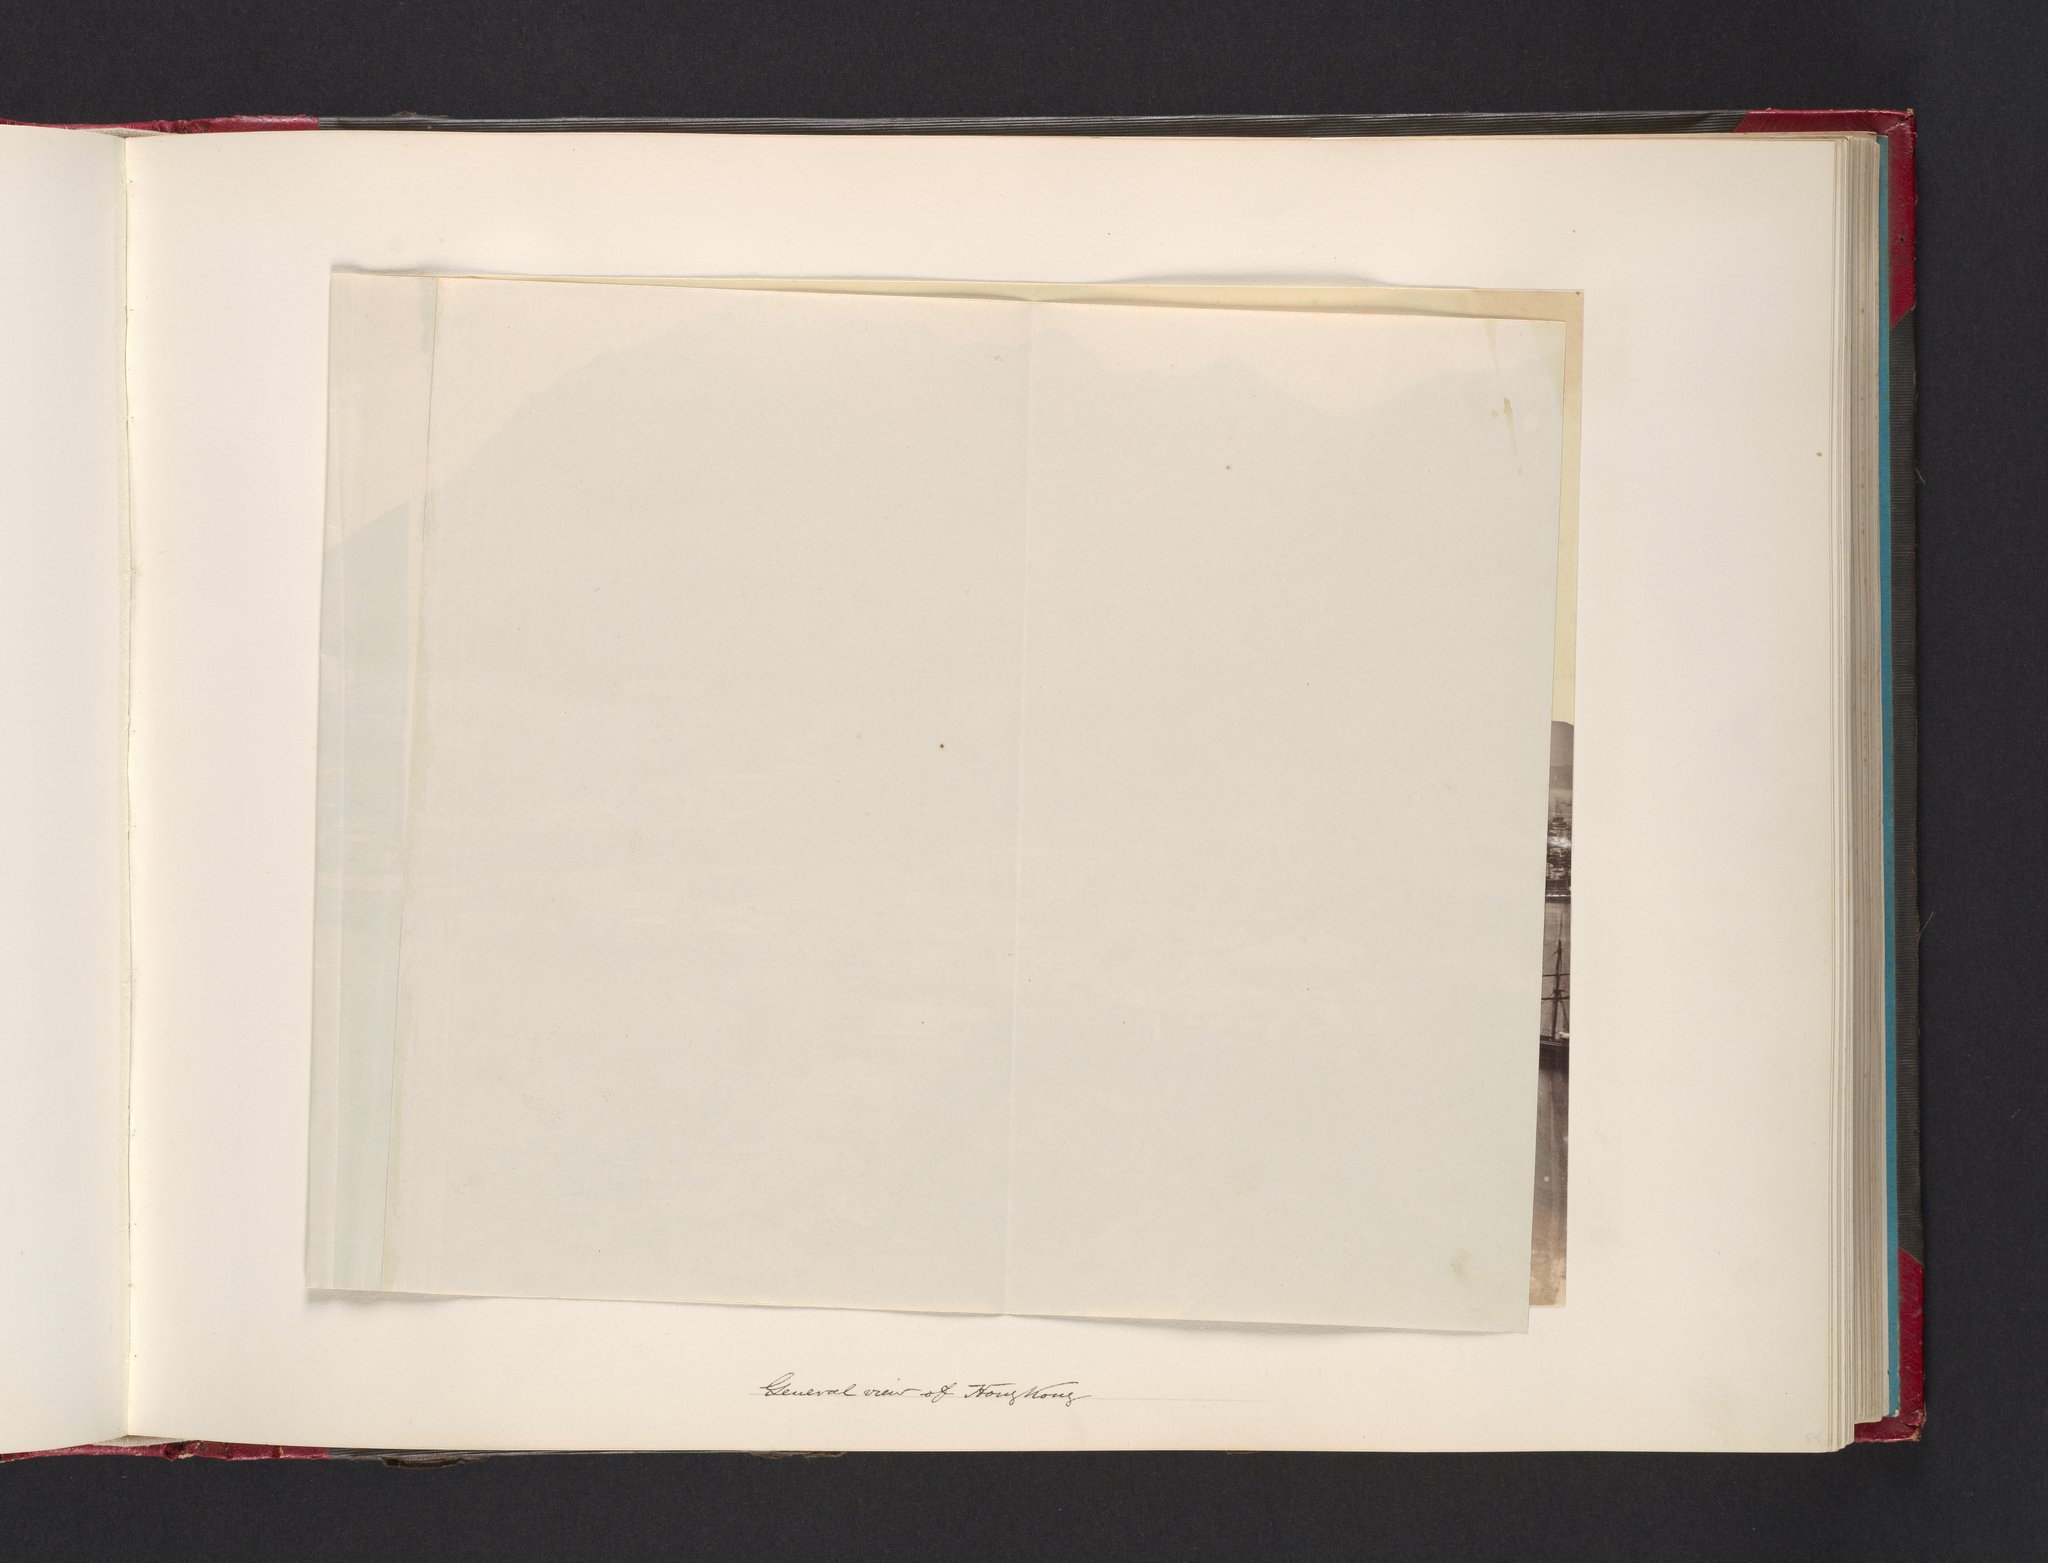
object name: photograph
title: General View of Hong Kong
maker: john thomson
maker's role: artist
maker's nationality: british, scottish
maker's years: 1837-1921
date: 1865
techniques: albumen silver print, glass negative